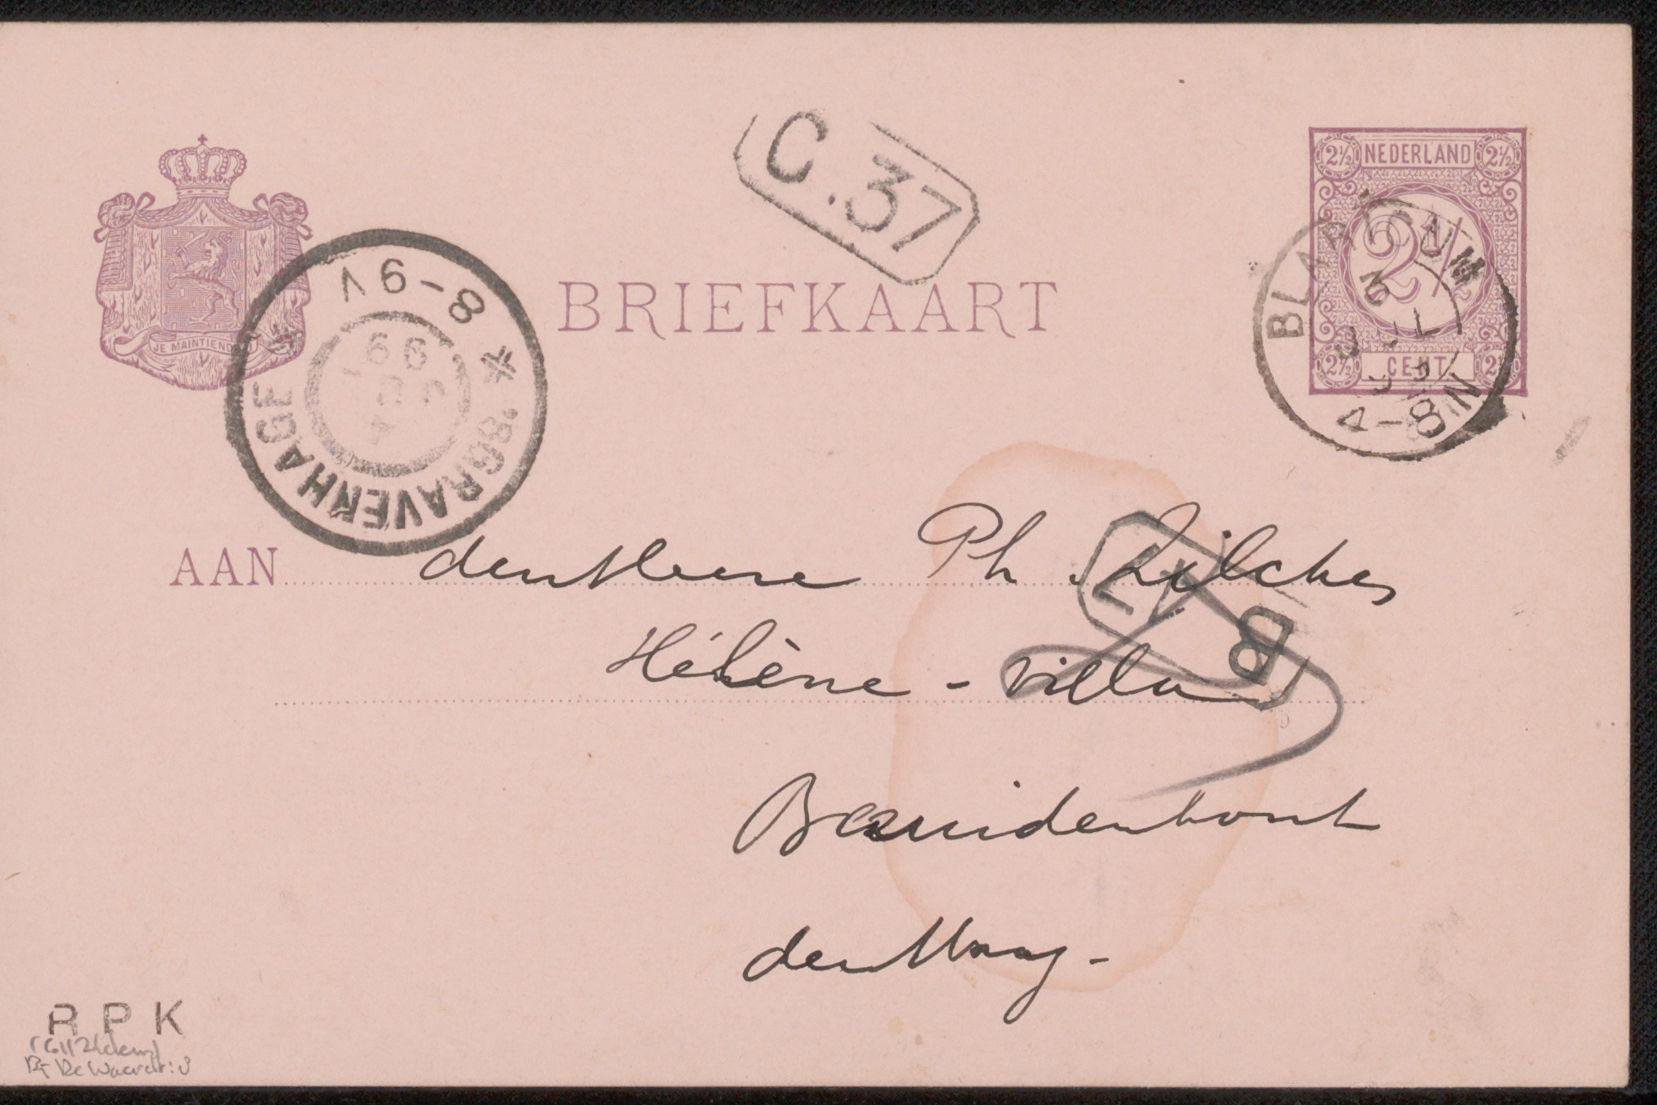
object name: postcard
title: Briefkaart aan Philip Zilcken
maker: jan de waardt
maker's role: draughtsman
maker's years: 1871-1909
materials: cardboard, ink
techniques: pen, writing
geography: blaricum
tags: painter, philip zilcken, drawing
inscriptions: collector's mark: ‘RPK’